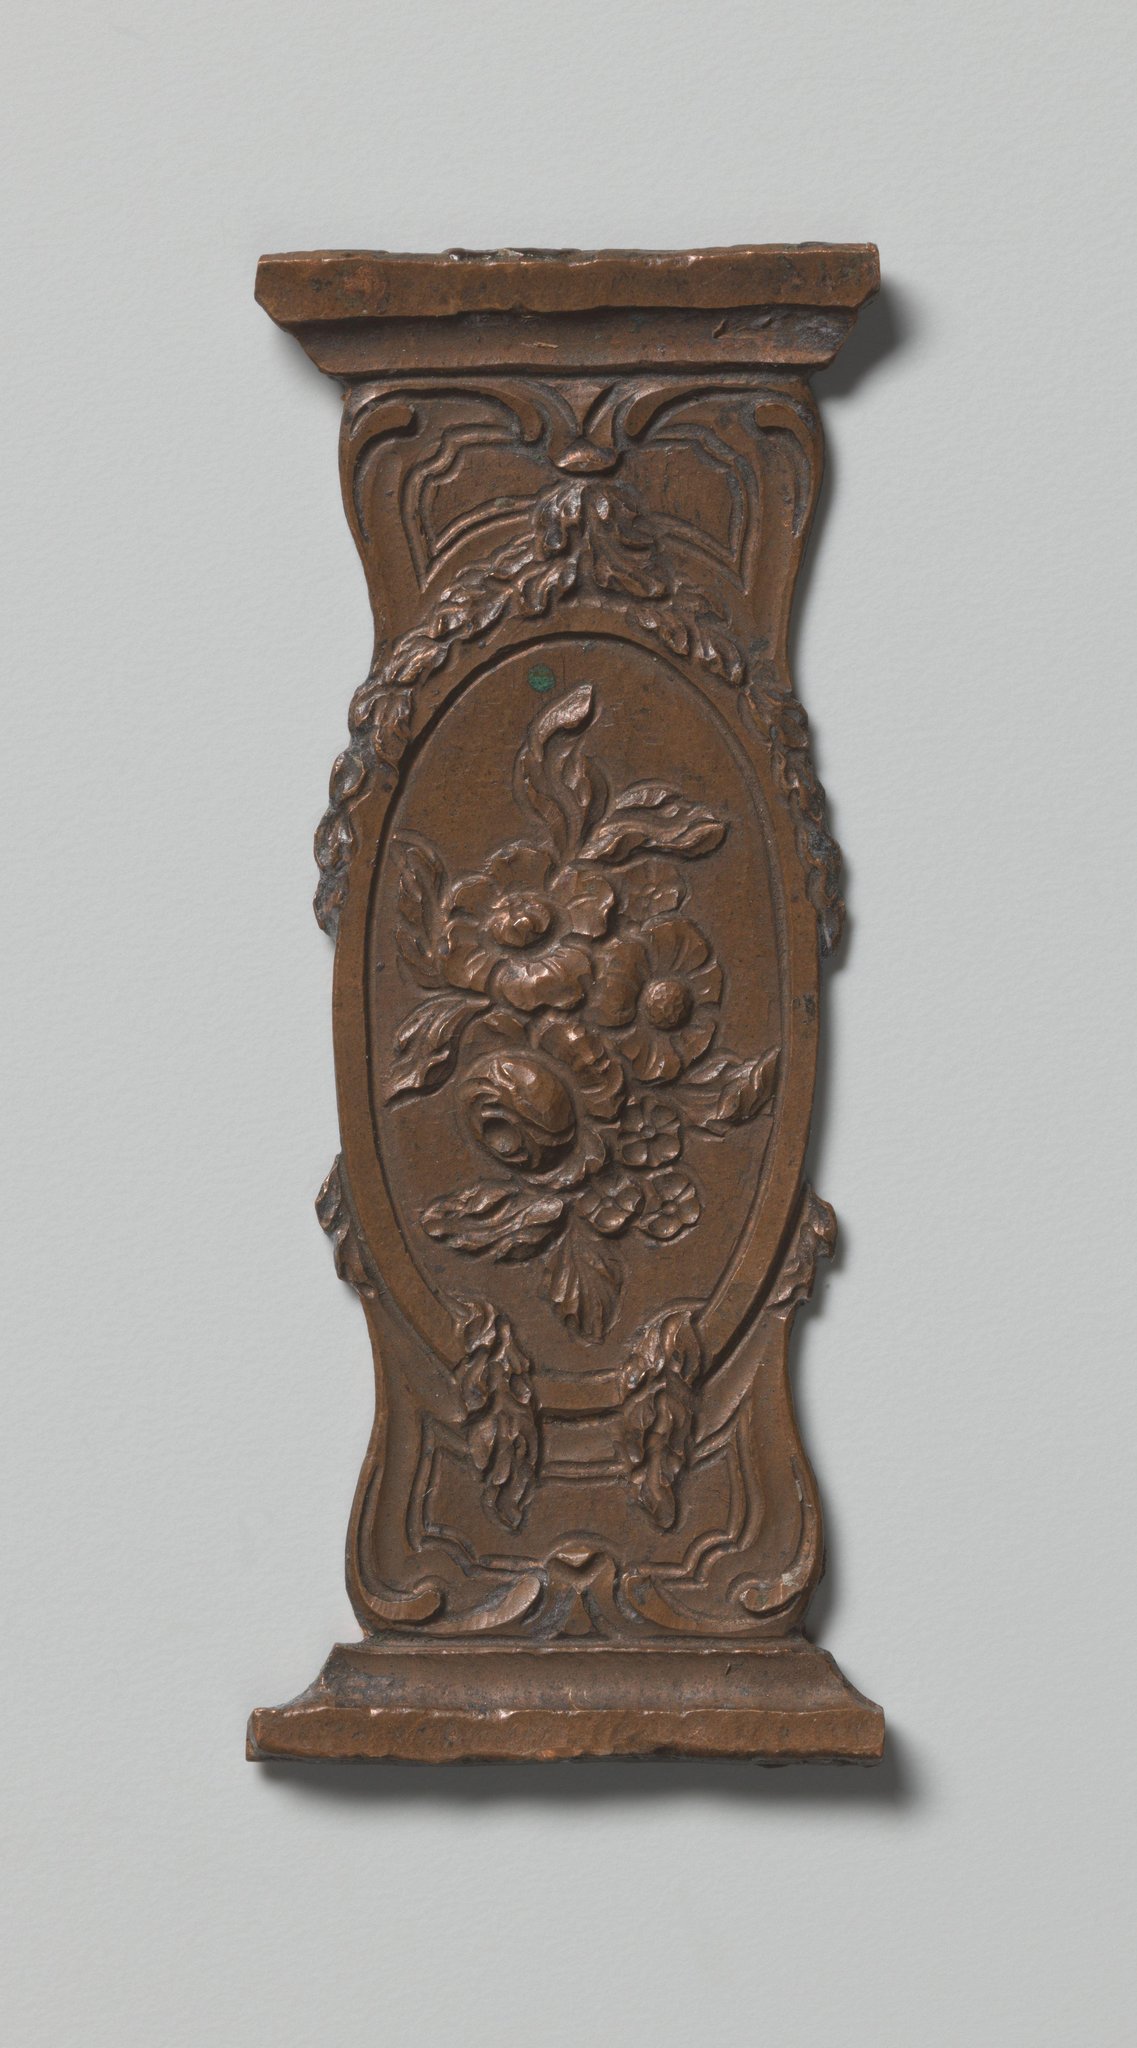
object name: model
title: Model voor een beugel van een boekslot met bloemen in een medaillon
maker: Anonymous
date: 1750-1775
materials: copper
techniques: repoussé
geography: amsterdam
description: Het uit plaat gedreven model voor een gietvorm is versierd met bloemen in een medaillon, omgeven door een slinger en ander ornament.